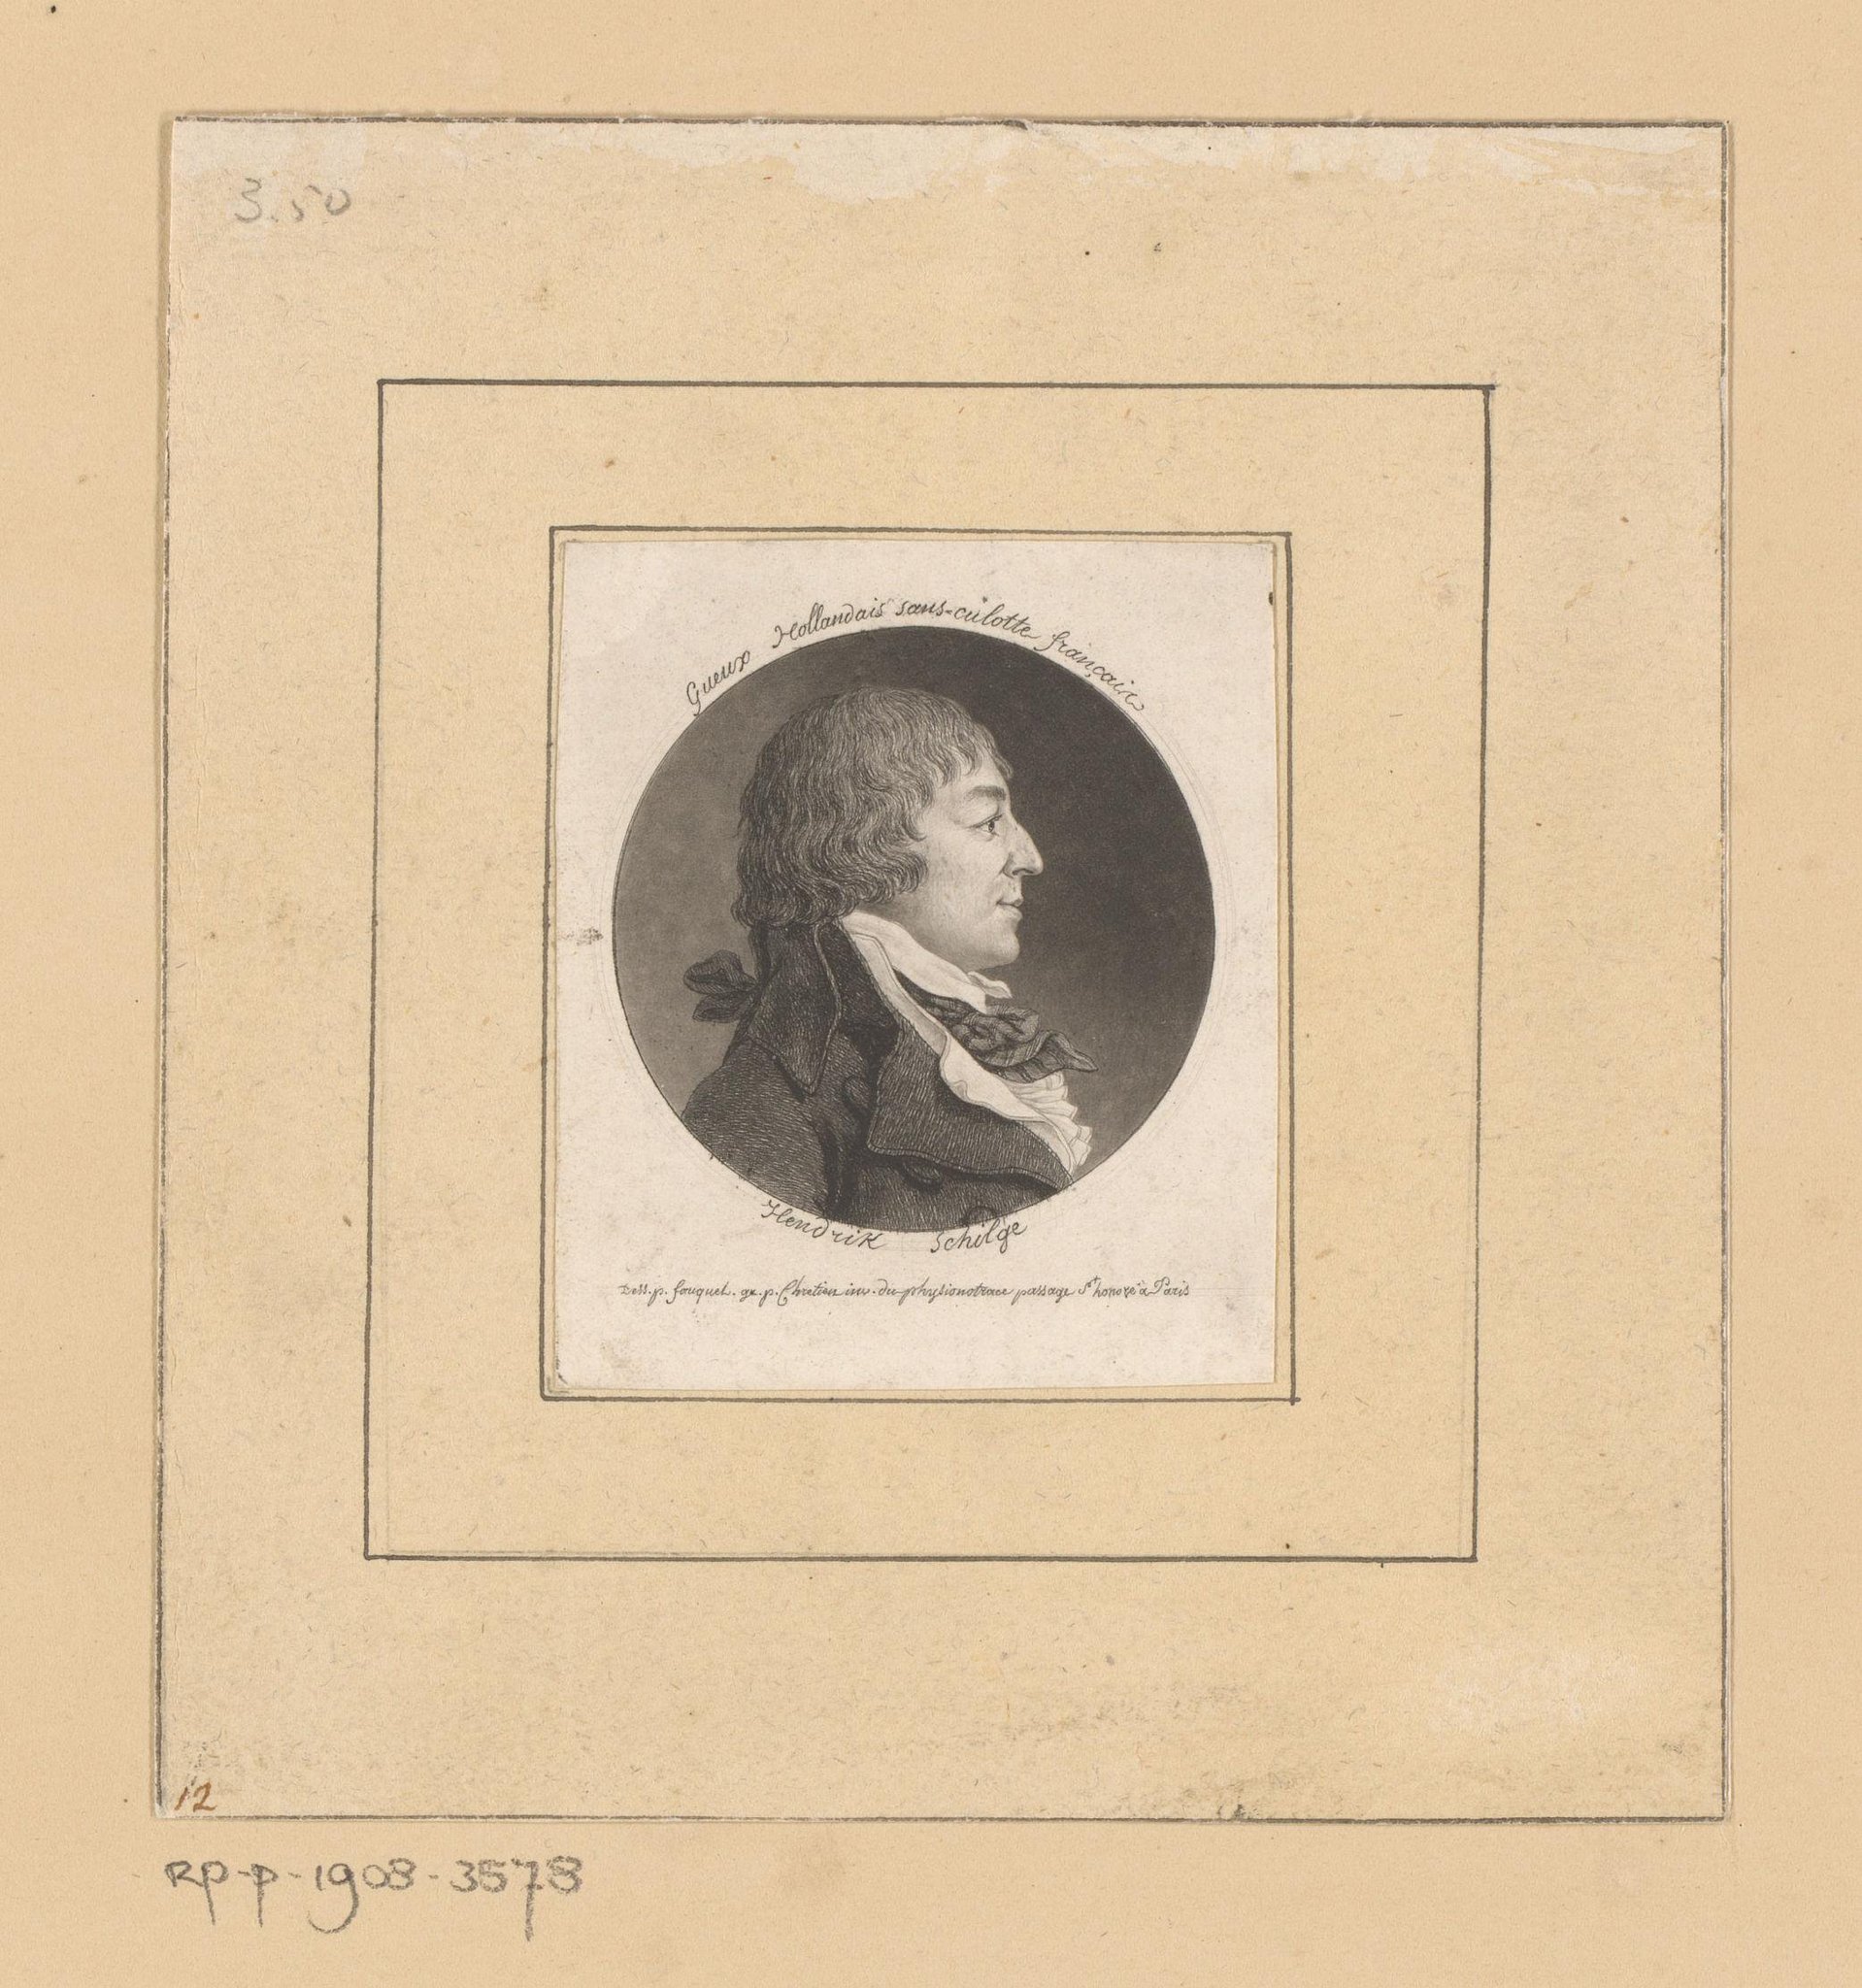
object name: physionotrace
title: Gueux hollandais sans-culotte français Hendrik Schilge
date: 1785-1811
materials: paper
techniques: aquatint, etching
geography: paris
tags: politician, silhouette-apparatus, 'physionotrace', historical persons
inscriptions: collector's mark: Lugt 2228